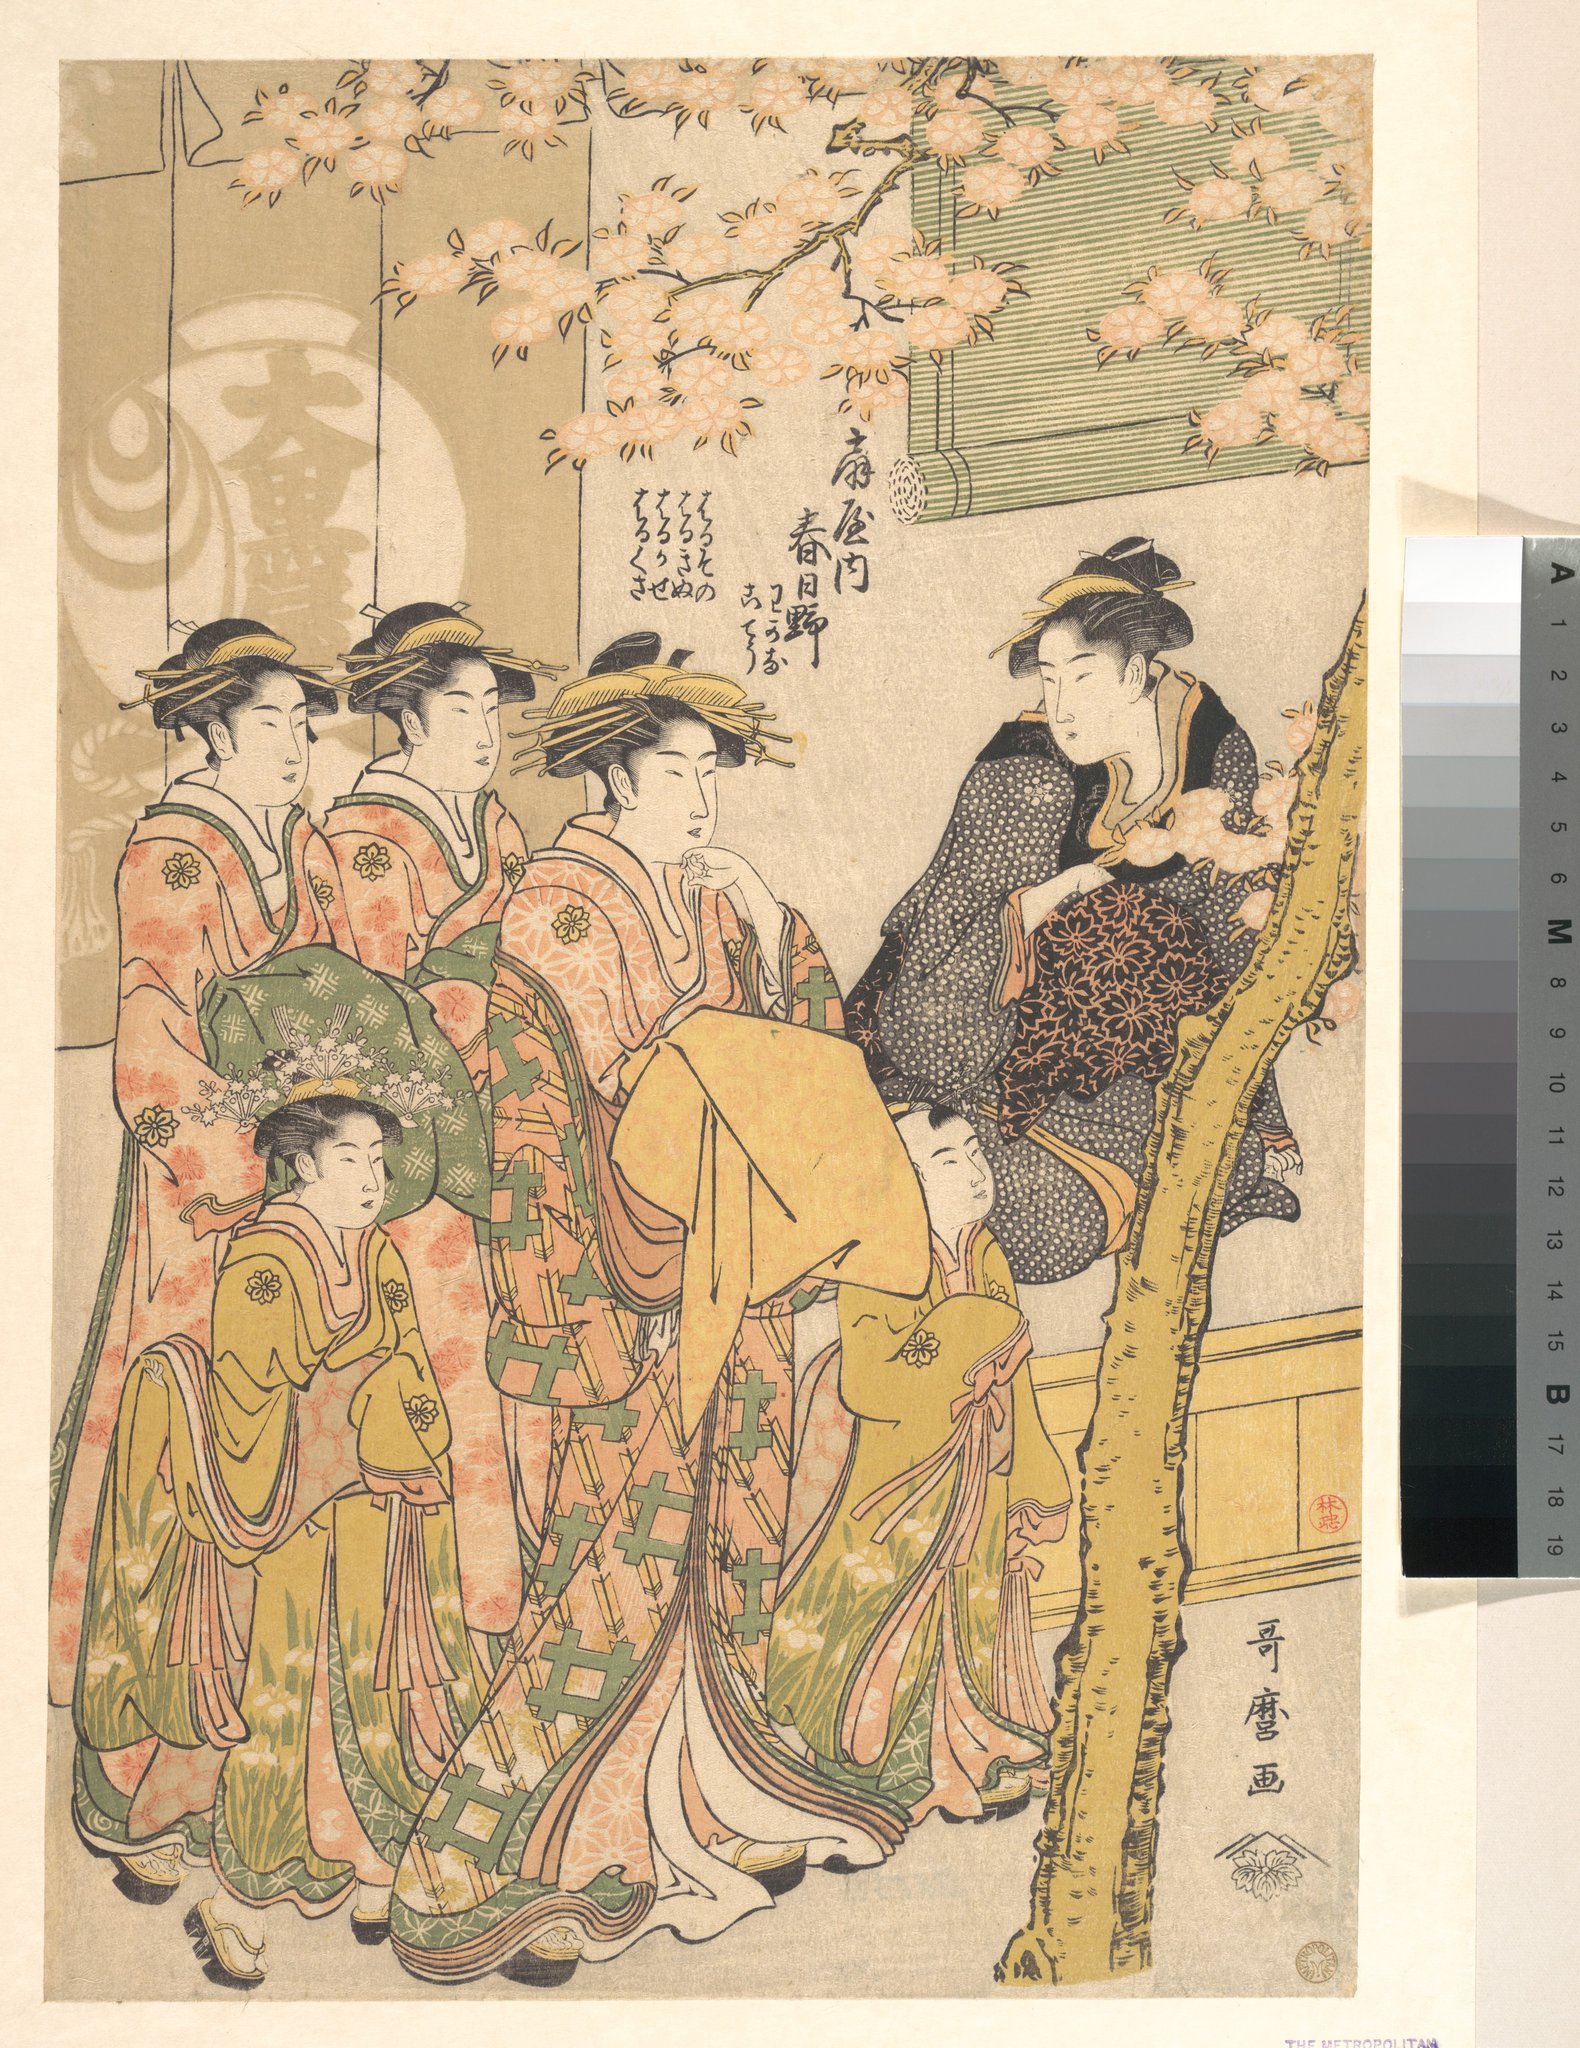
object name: print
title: The Oiran Kasugano of Ogiya on Parade under Blossoming Cherry Trees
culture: japanese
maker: kitagawa utamaro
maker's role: artist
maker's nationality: japanese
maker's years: 1754-1806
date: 1788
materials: ink, paper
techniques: woodblock print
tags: women,trees